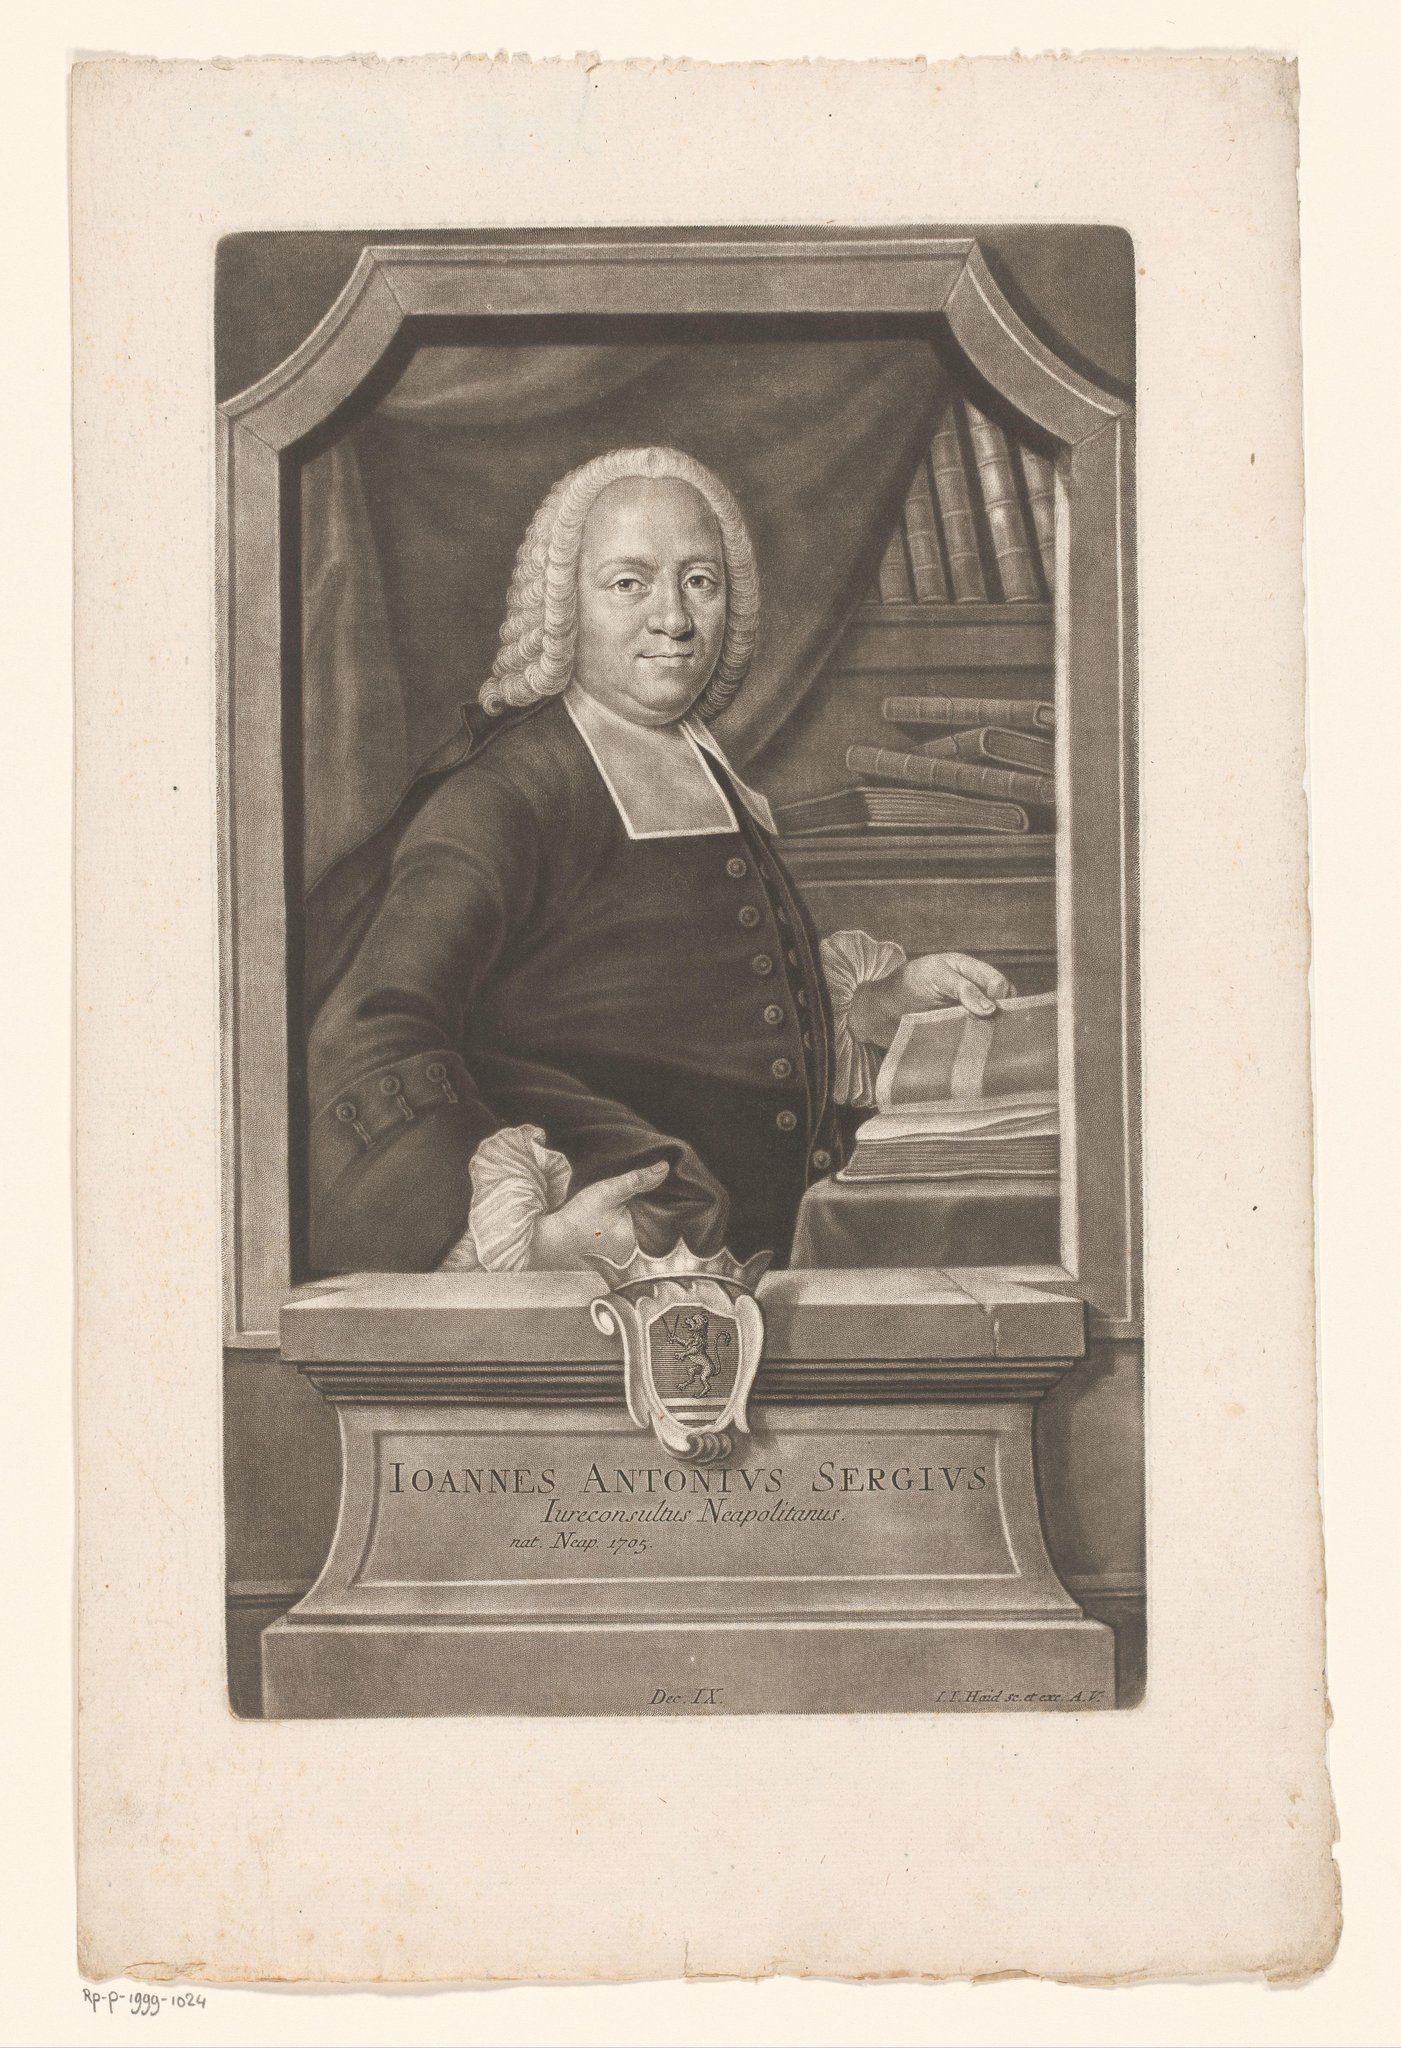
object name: print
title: Portret van Giovanni Antonio Sergio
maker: johann jacob haid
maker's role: print maker, publisher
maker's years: 1704-1767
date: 1752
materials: paper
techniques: etching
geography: augsburg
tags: bookshelves, historical persons, armorial bearing, heraldry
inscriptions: collector's mark: Lugt 2760, collector's mark: Lugt 2228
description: Prent gebruikt voor: Brucker, Jacob. Bildersal heutiges Tages lebender und durch Gelahrheit berühmter Schrifftsteller. Augsburg: Johann Jacob Haid, 1752.